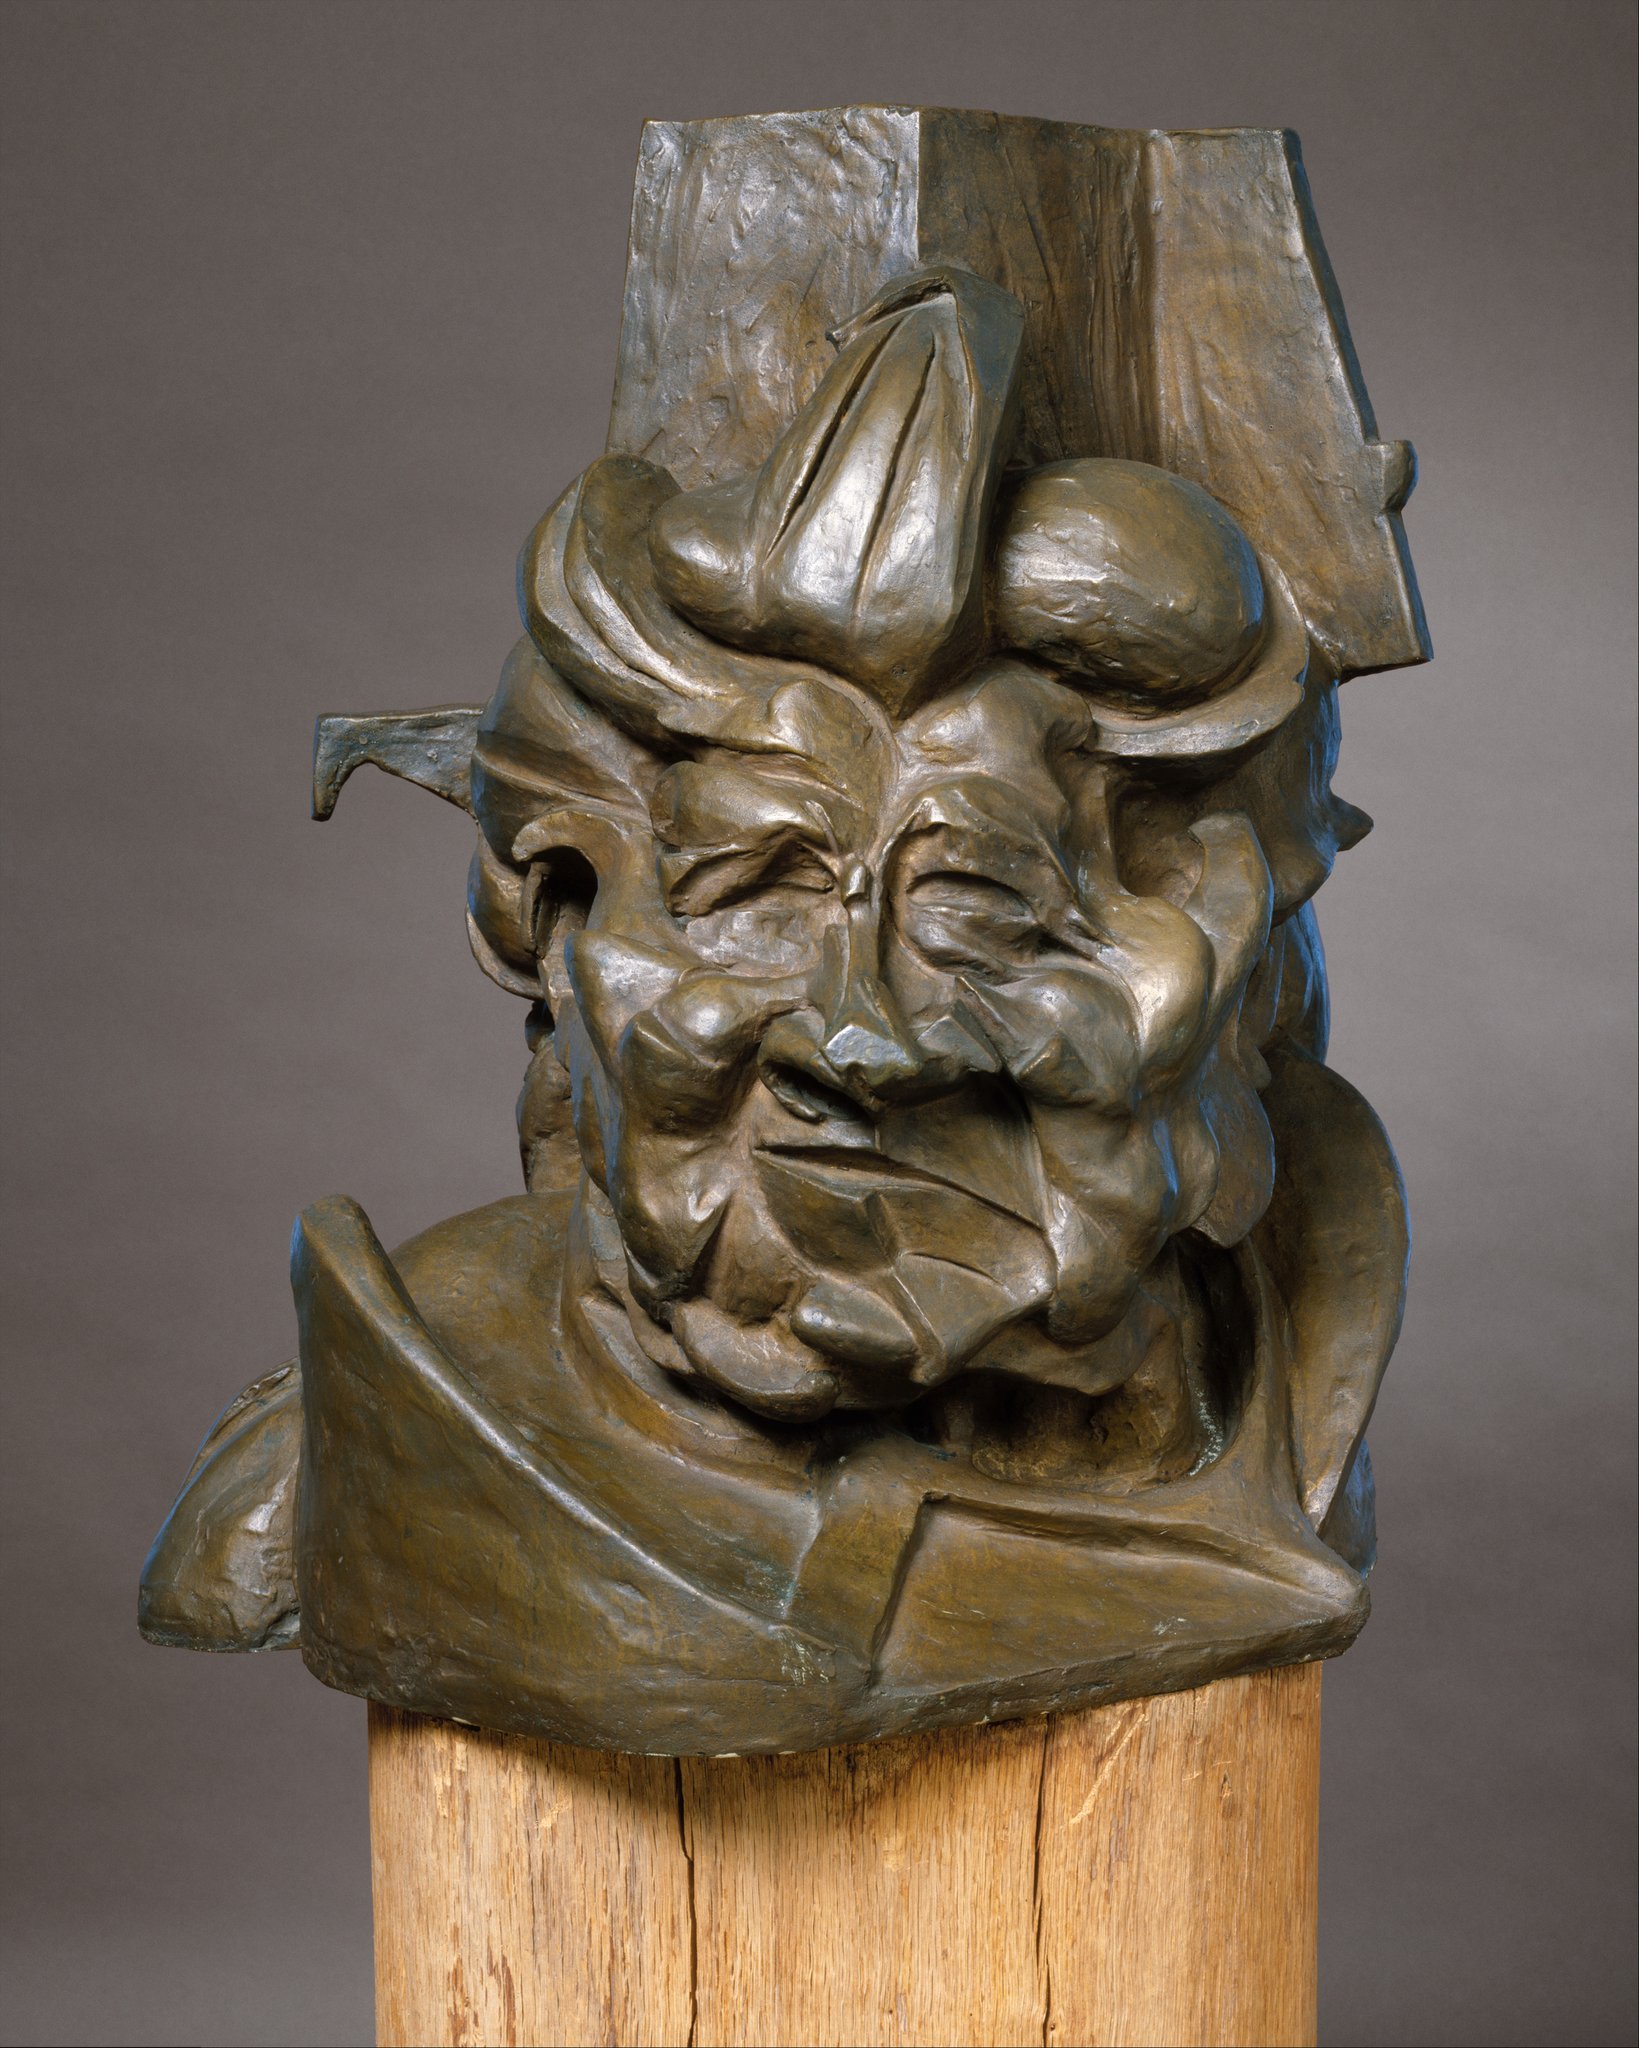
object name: sculpture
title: Antigraceful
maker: umberto boccioni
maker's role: artist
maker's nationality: italian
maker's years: 1882-1916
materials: bronze